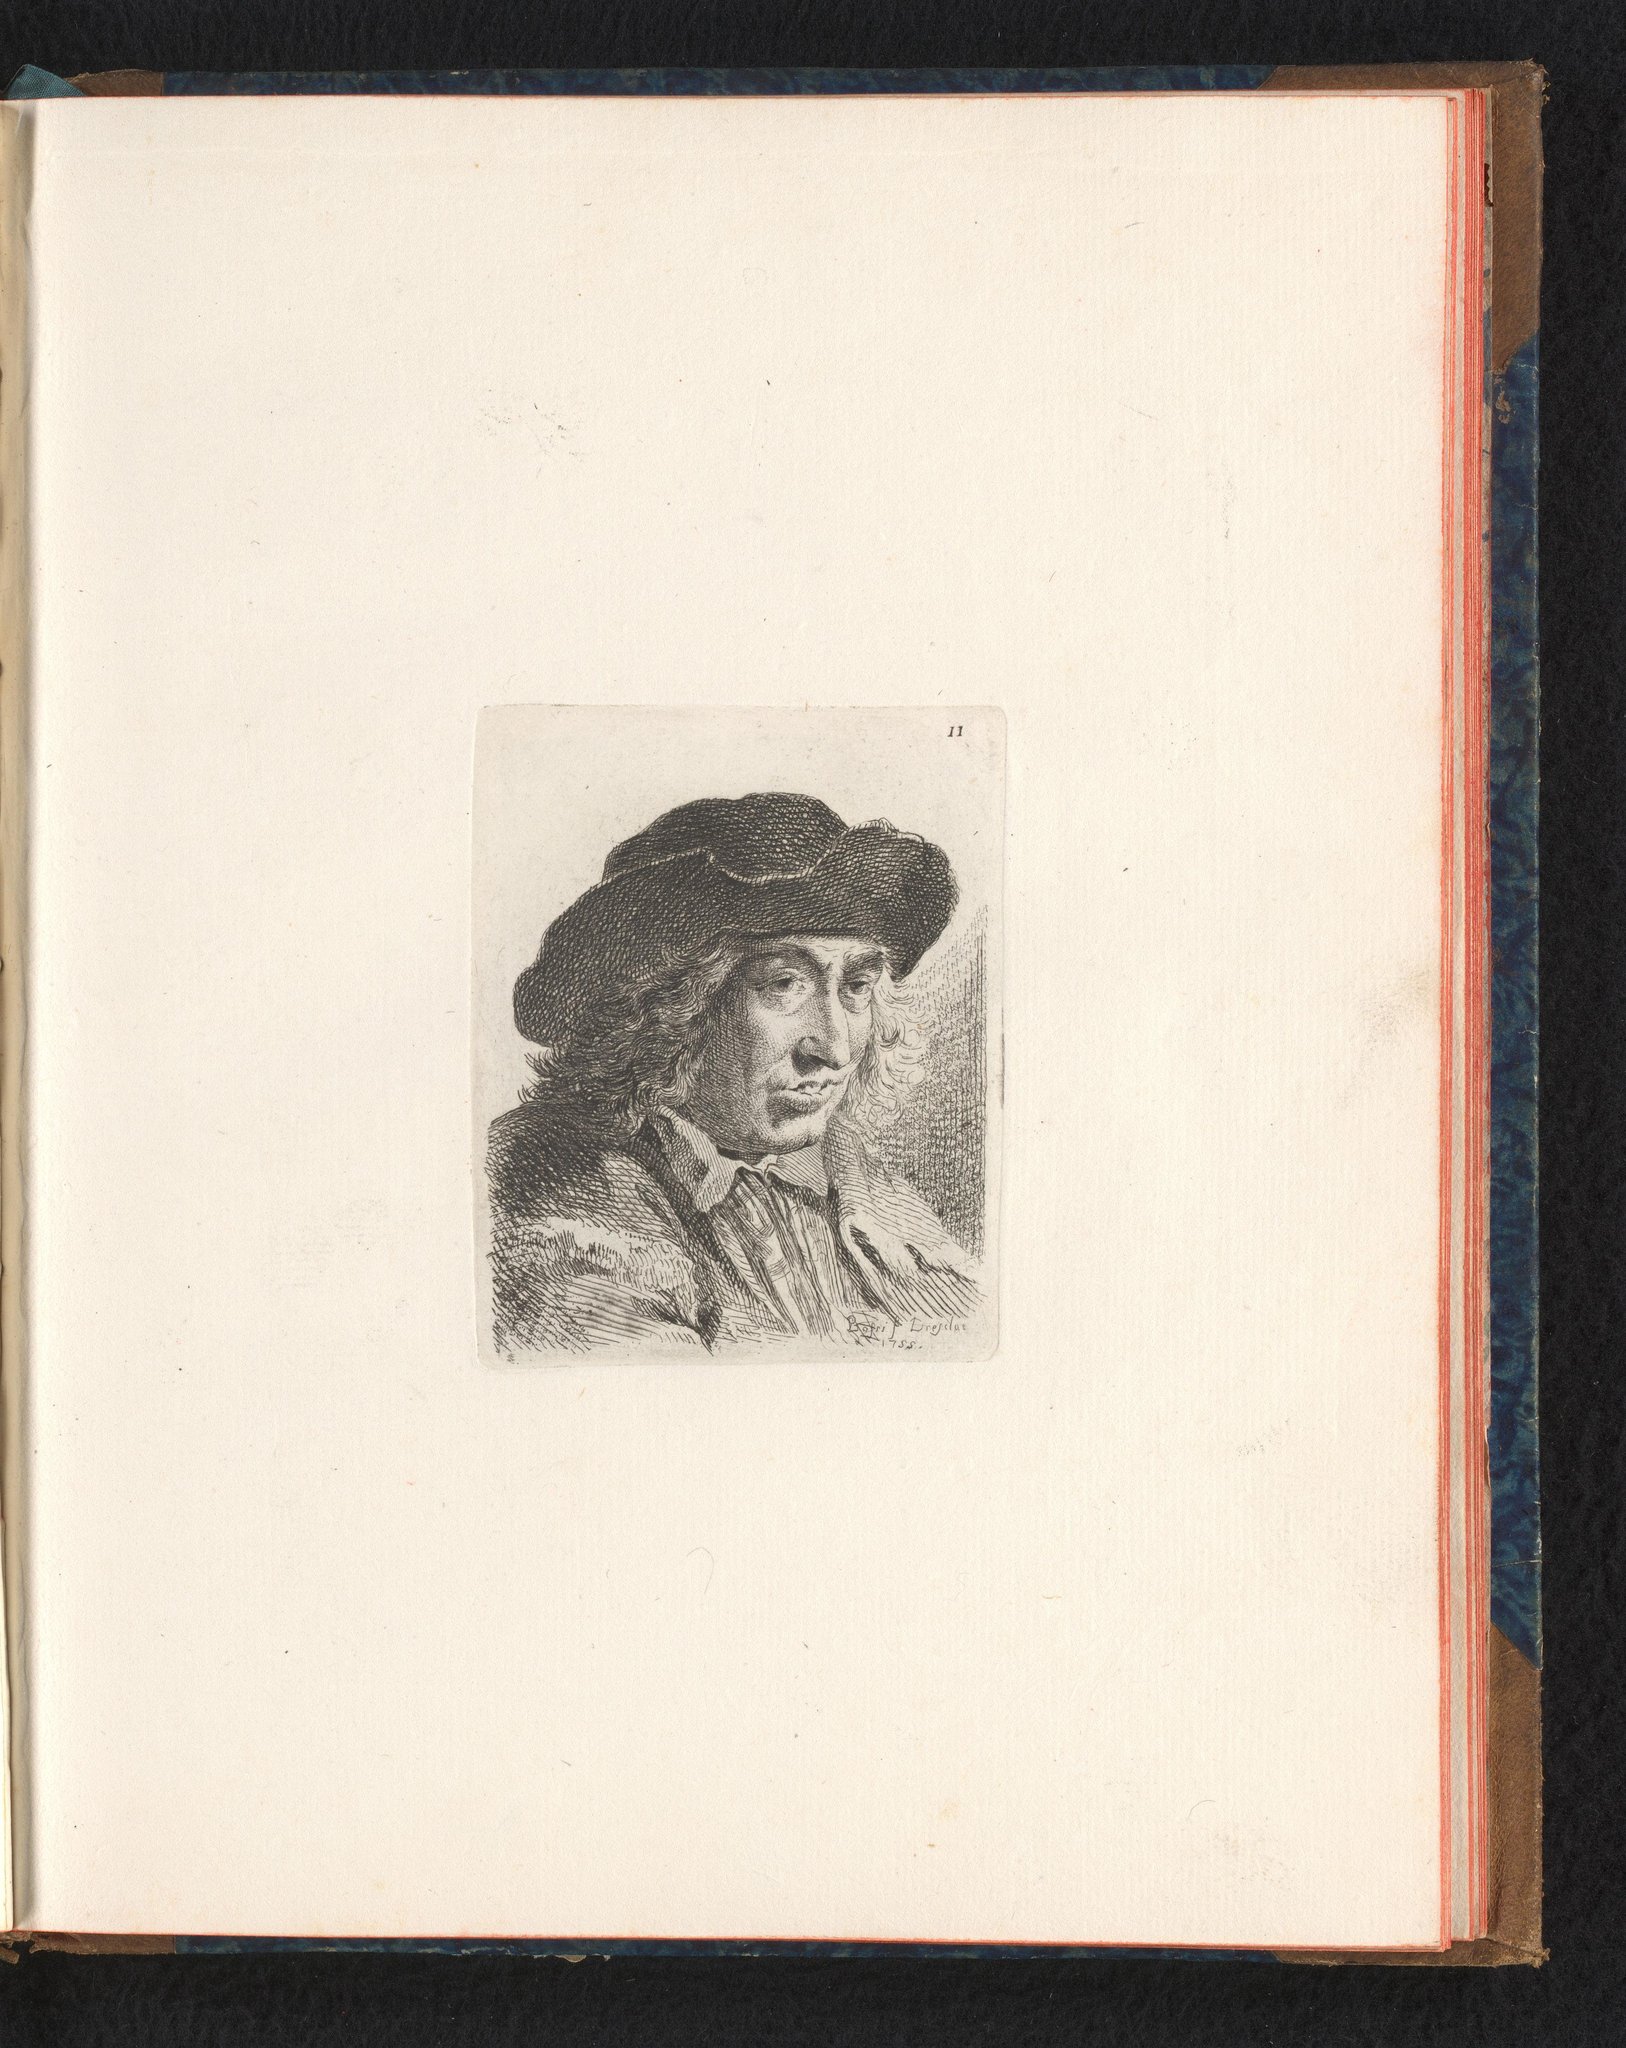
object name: print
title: Hoofd van een man met hoed naar rechts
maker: benigno bossi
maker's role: print maker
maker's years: 1727-1792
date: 1755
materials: paper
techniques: etching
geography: parma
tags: head (human), head-gear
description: De prent is waarschijnlijk in de eerste staat uitgegeven onder de serietitel: Prove d"aqua forte. De prent is in de tweede staat ook uitgegeven onder de serietitel: Raccolta di teste inventate, disegnate ed incise da Benigno Bossi.